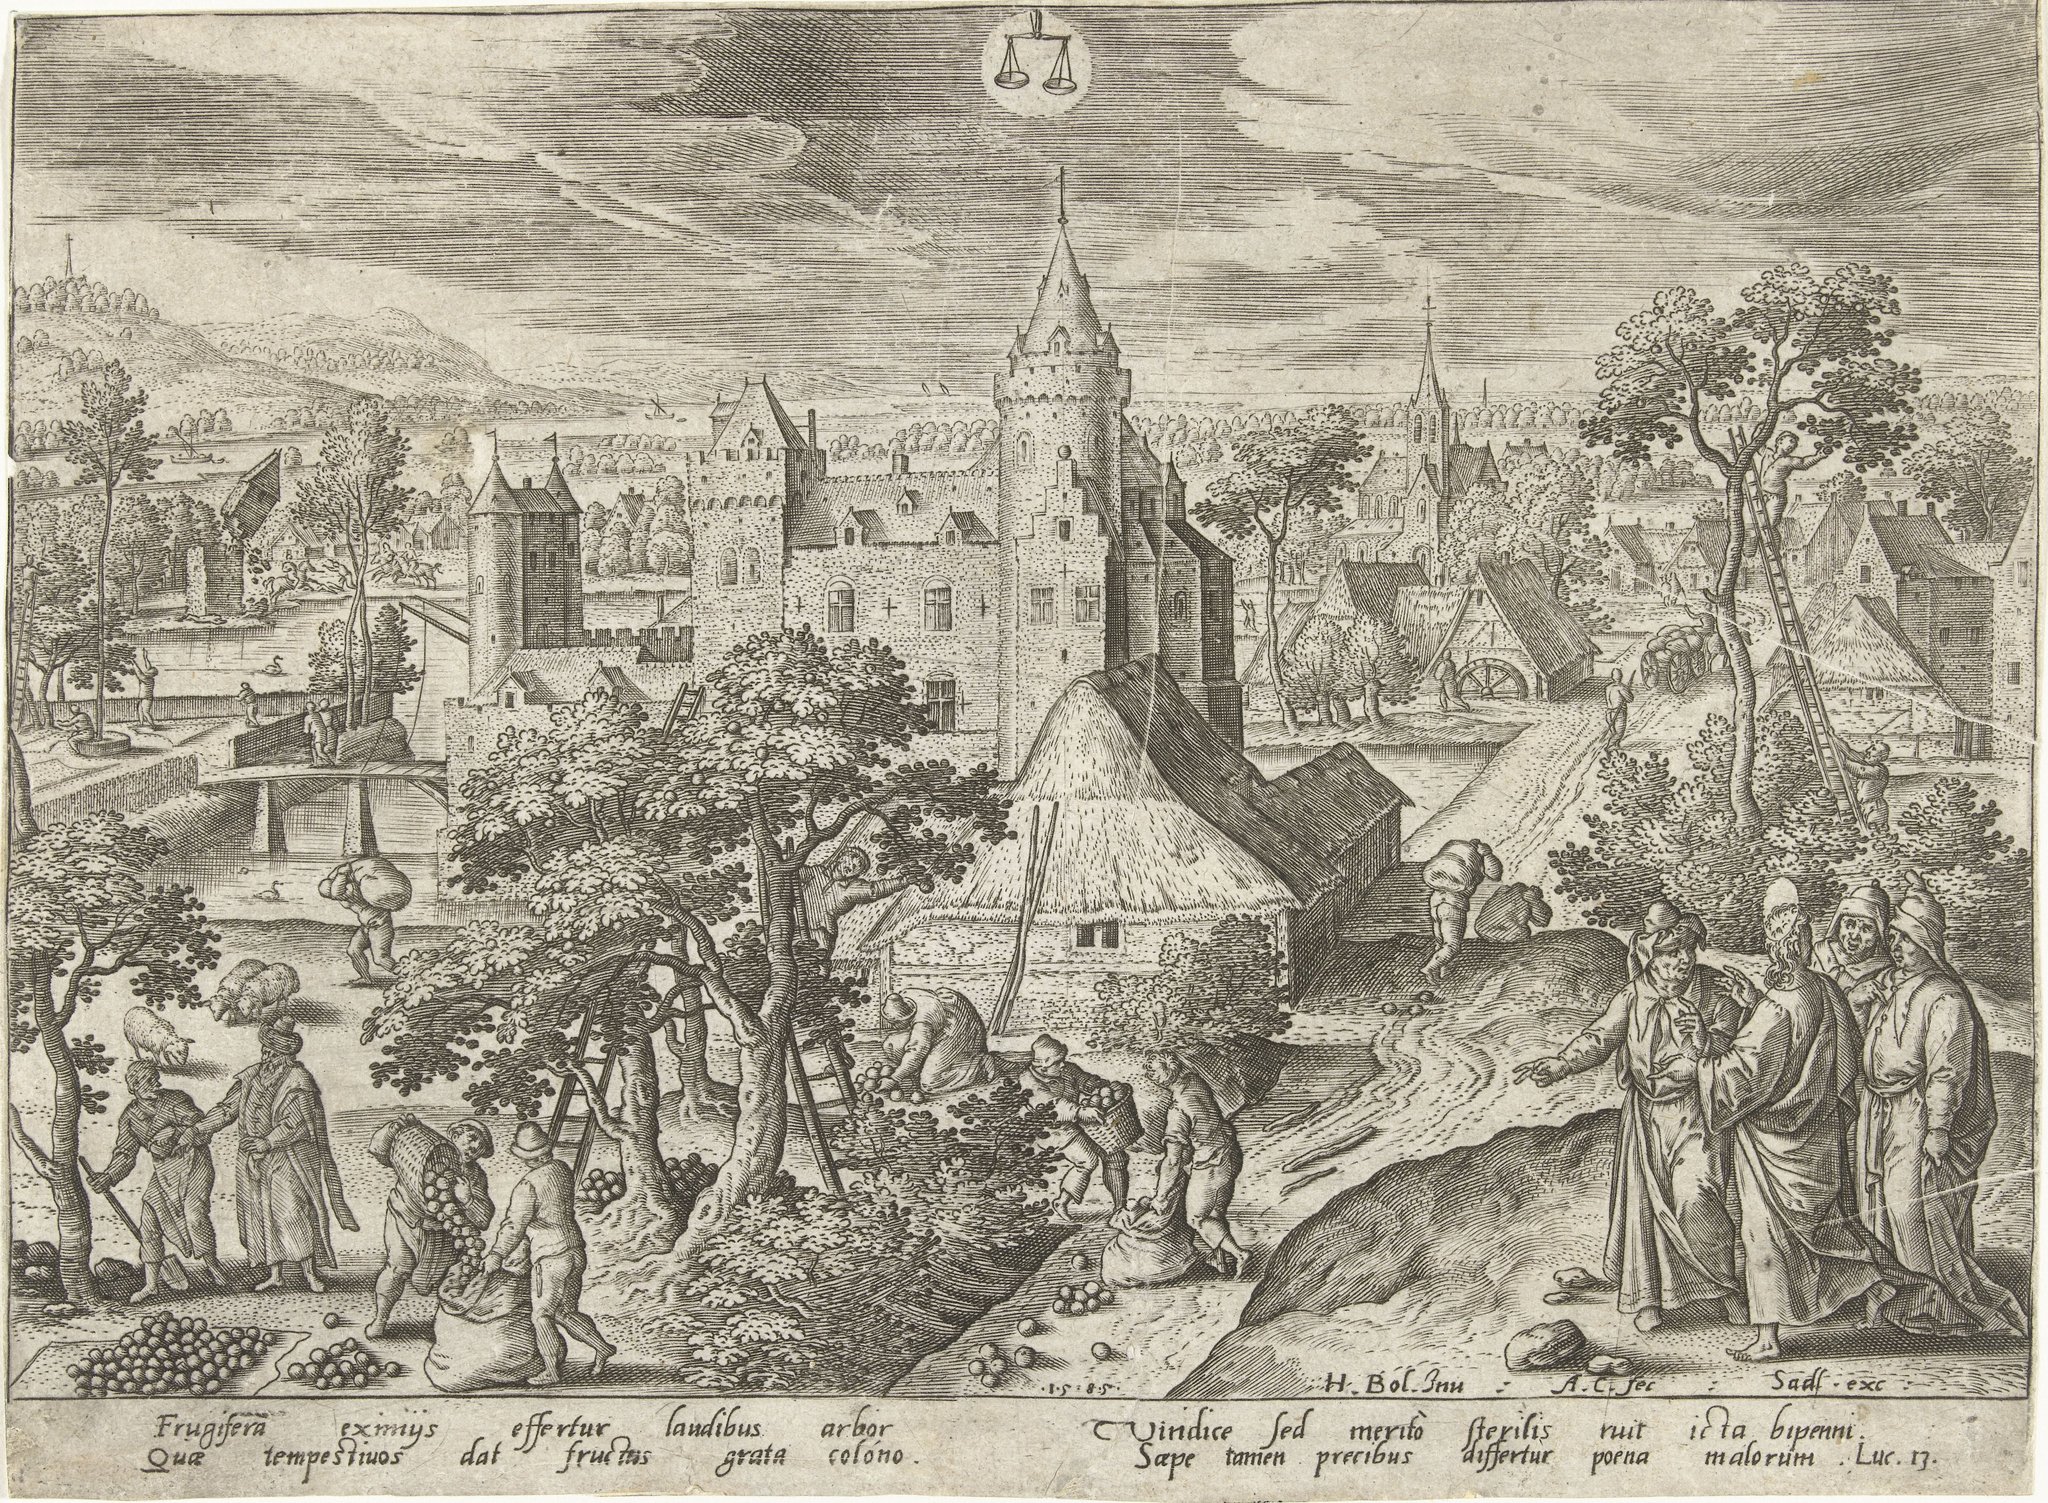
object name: print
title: Het leven van Christus in de twaalf maanden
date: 1585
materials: paper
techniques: engraving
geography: antwerp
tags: fruit harvest, landscape symbolizing september (+ with libra (september)), the fig-tree in the vineyard, which did not bear fruits ~ parable of christ (luke 13:6-9)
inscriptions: collector's mark: Lugt 2760, collector's mark: Lugt 2228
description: Een herfstlandschap. In de lucht het astrologisch teken van september: Weegschaal. Christus vertelt de parabel van de dorre vijgenboom aan zijn leerlingen (Luc. 13). Op de achtergrond het binnenhalen van de fruitoogst. Linksonder beveelt een boer zijn knecht een fruitboom zonder vruchten om te hakken. De prent heeft een Latijns onderschrift en is deel van een serie over het leven van Christus uitgebeeld in de twaalf maanden van het jaar.